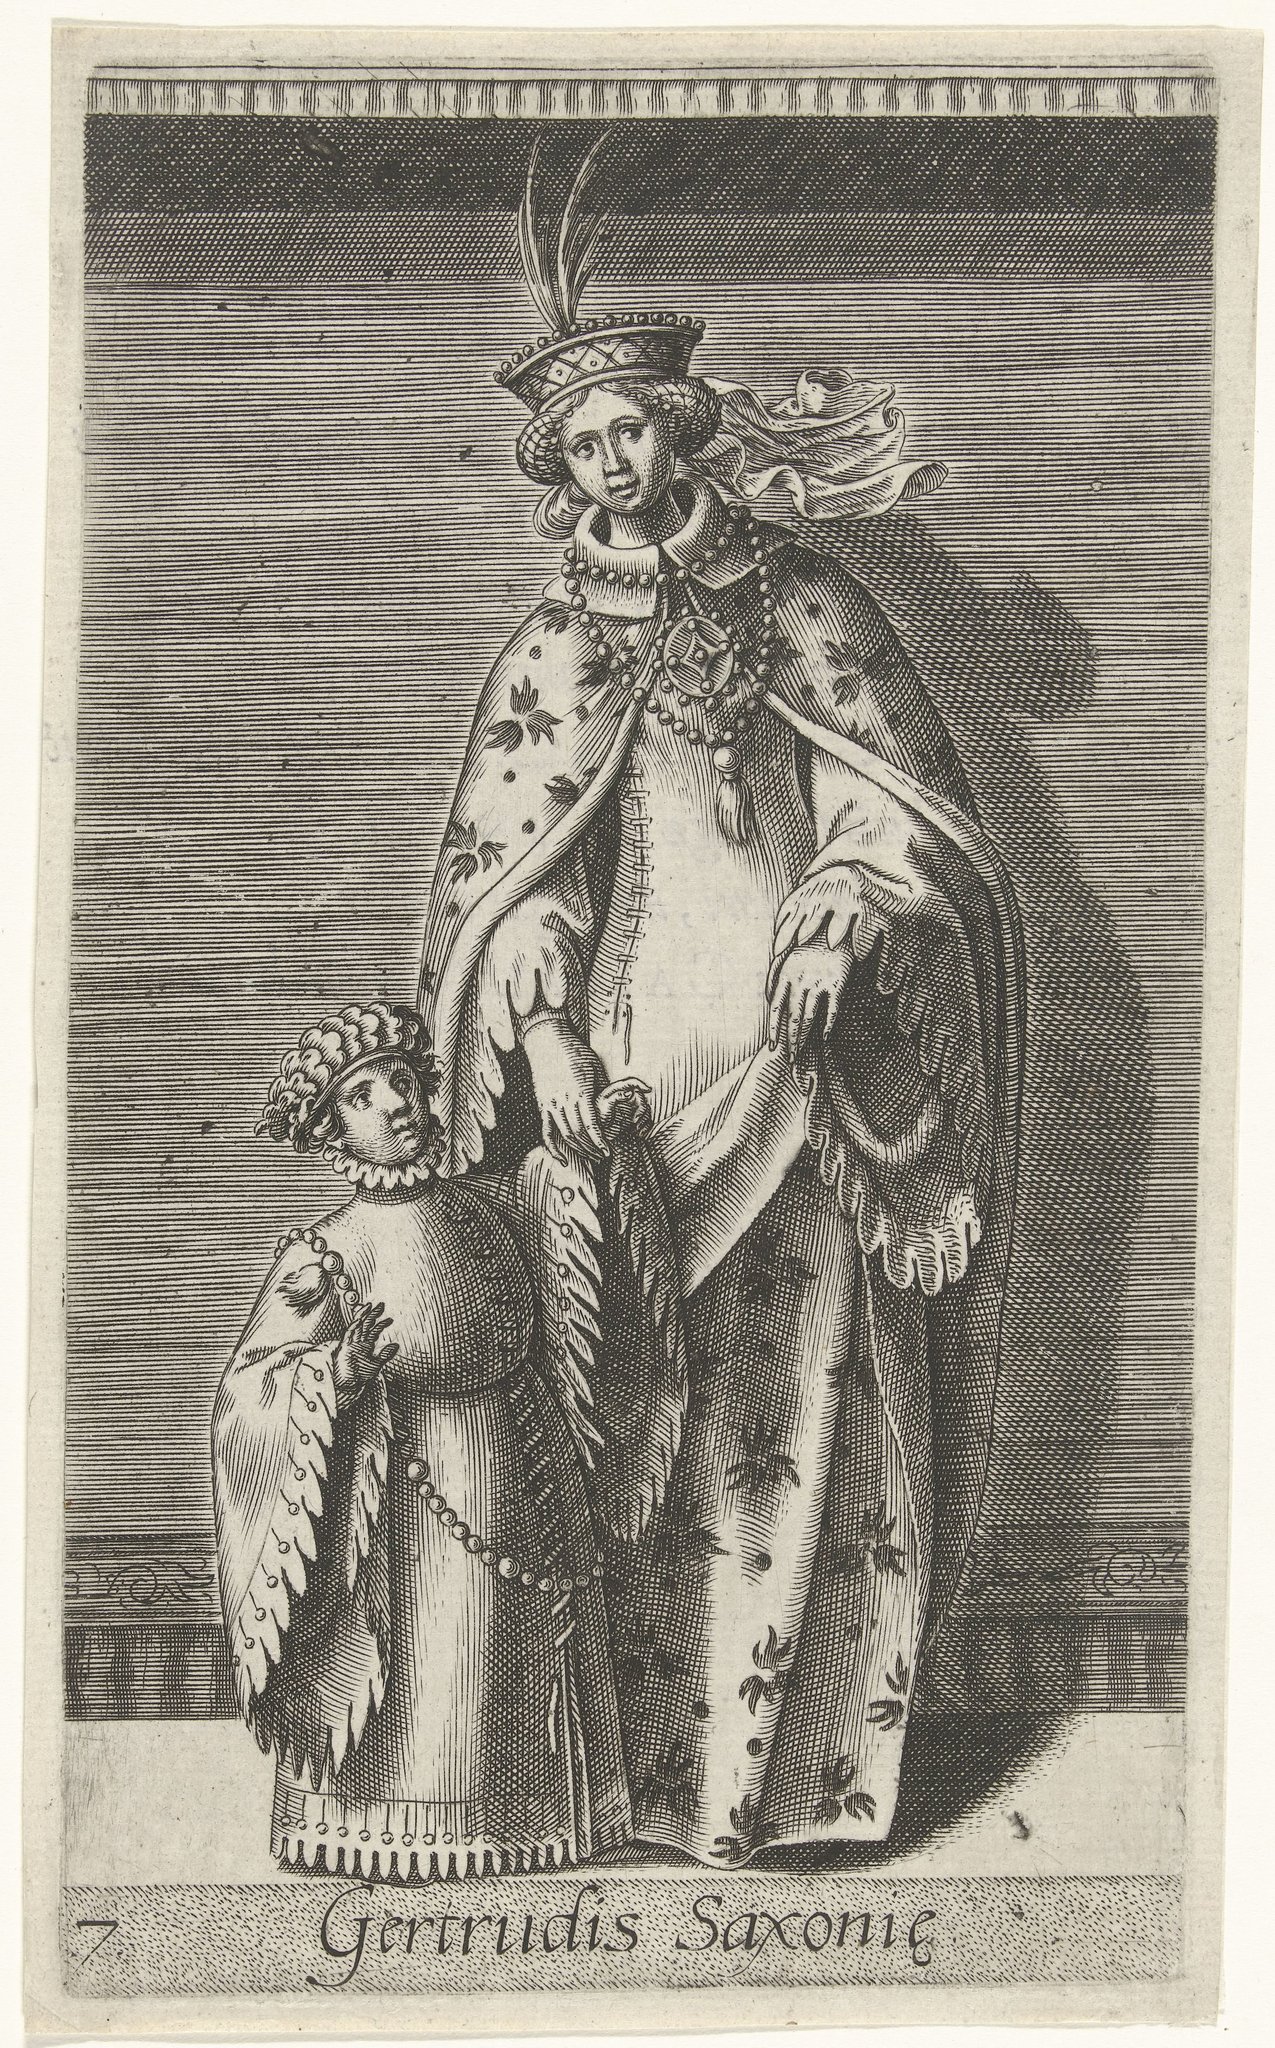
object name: print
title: Portret van Geertruida van Saksen,gravin van Holland en Dirk V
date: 1578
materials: paper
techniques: engraving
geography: antwerp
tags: politician, earl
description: Geertruida van Saksen, gravin van Holland. Staande, ten voeten uit. Zij was regentes gedurende de minderjarigheid van Dirk V, die naast haar staat. De prent dient als een illustratie bij een boek over de geschiedenis van de graven van Holland